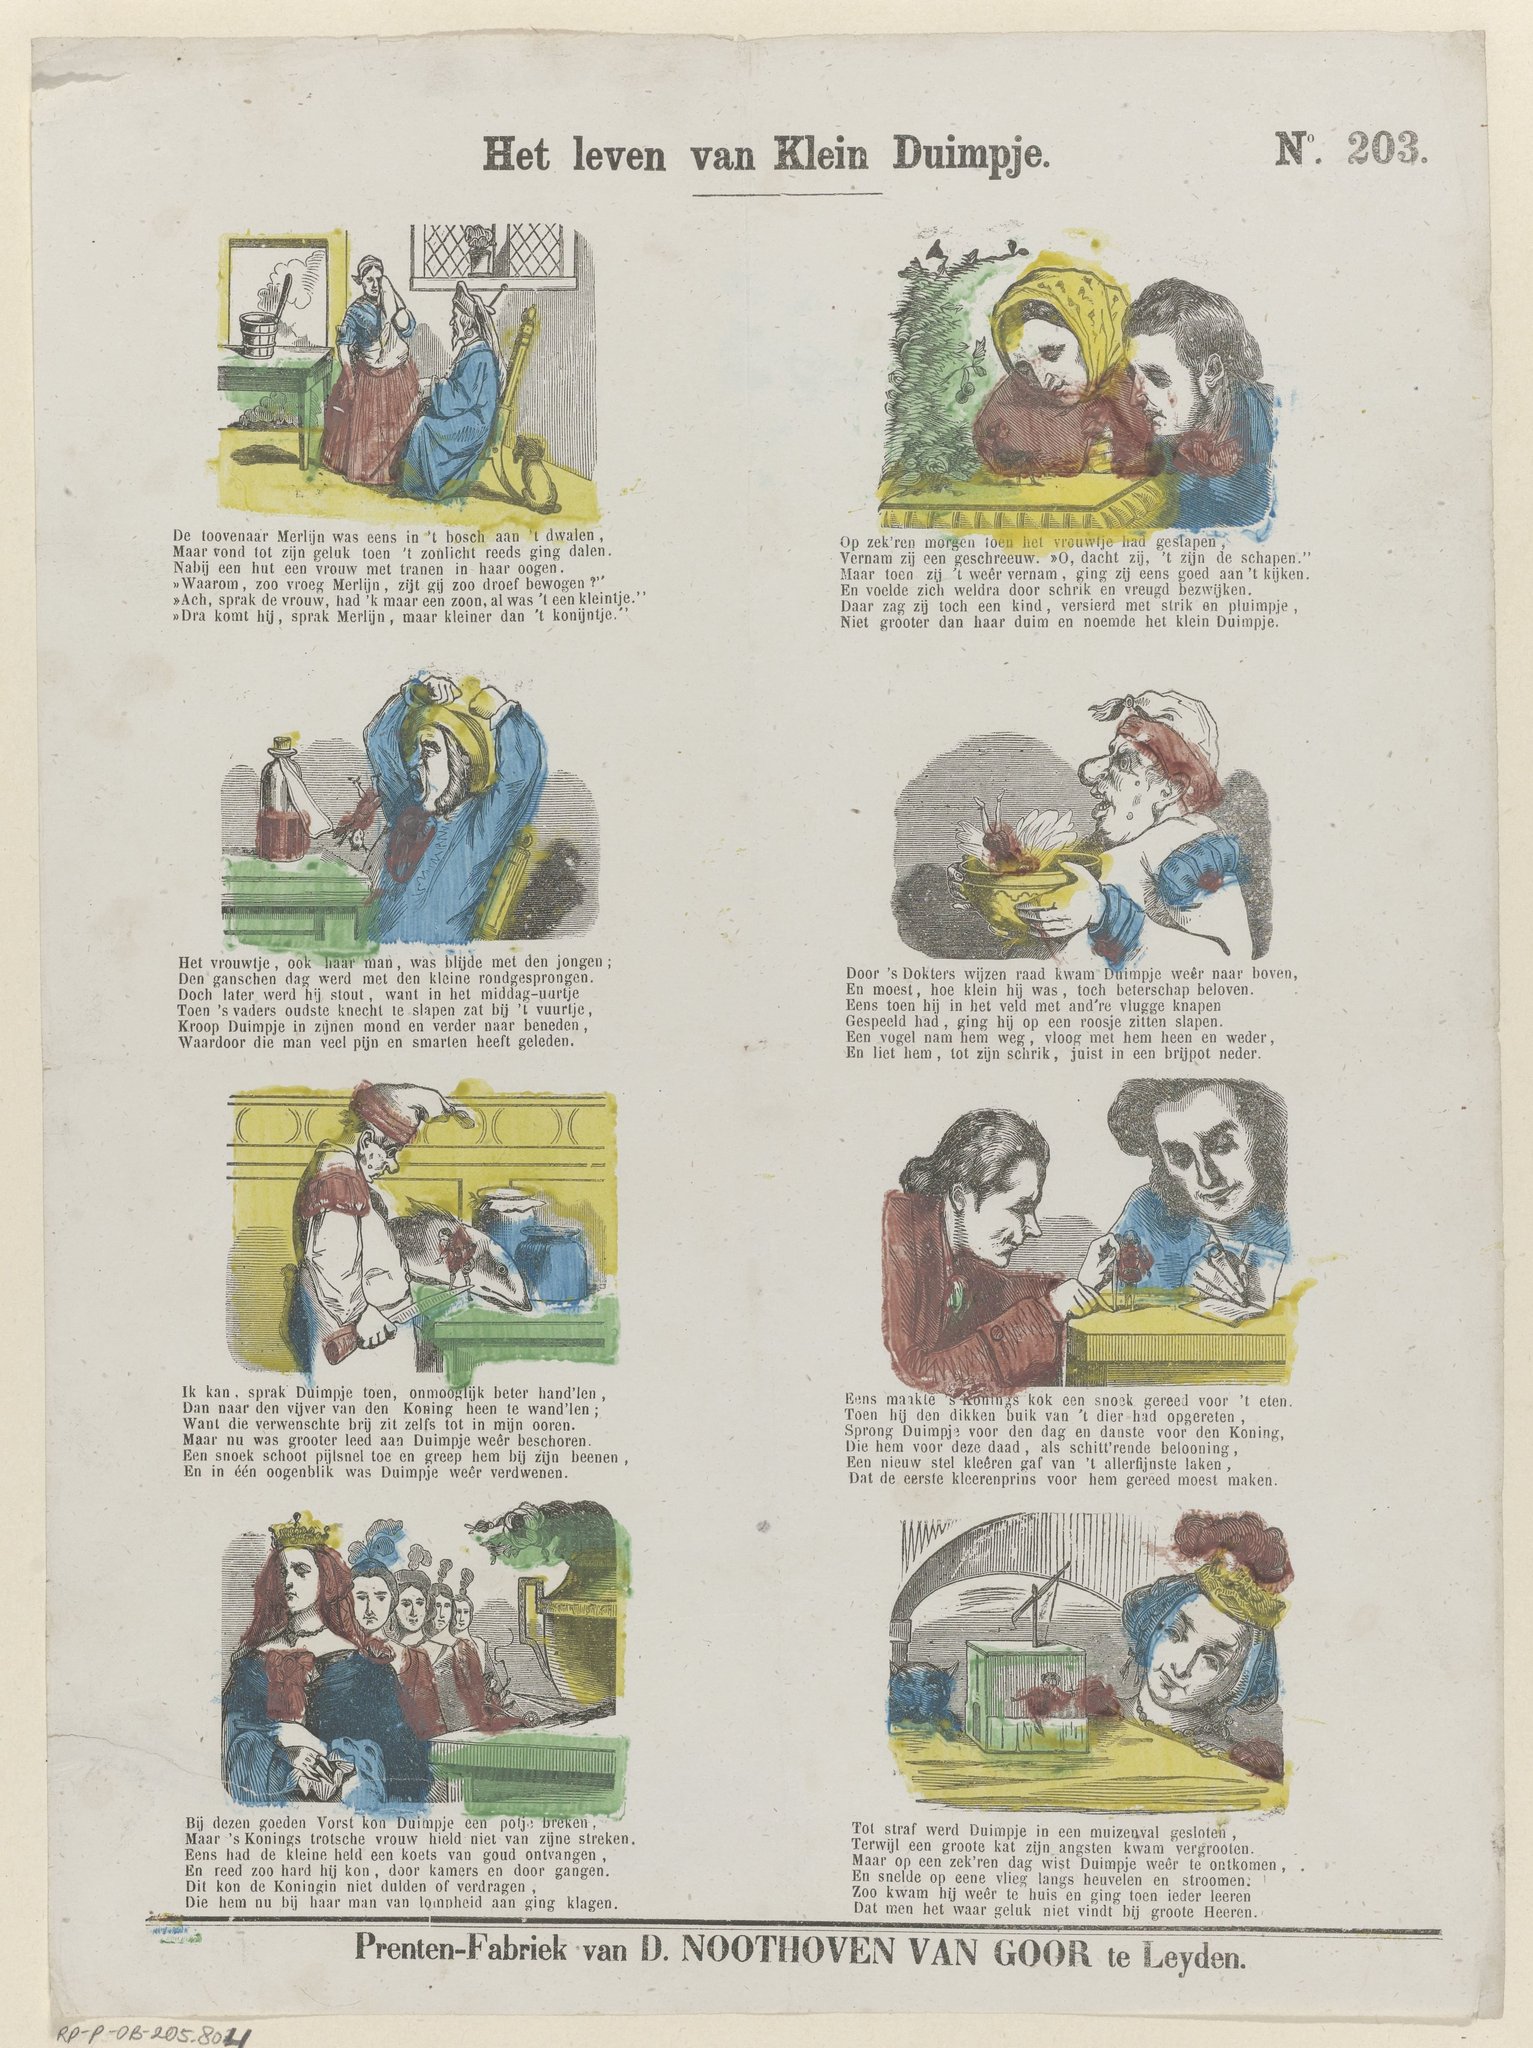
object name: print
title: Het leven van Klein Duimpje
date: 1850-1881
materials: paper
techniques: colour, letterpress printing, engraving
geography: leiden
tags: tales and fairy tales: little thumbling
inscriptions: collector's mark: Lugt 2760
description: Blad met 8 voorstellingen uit het sprookje van Klein Duimpje. Onder elke voorstelling een zesregelig vers. Genummerd rechtsboven: No. 203.